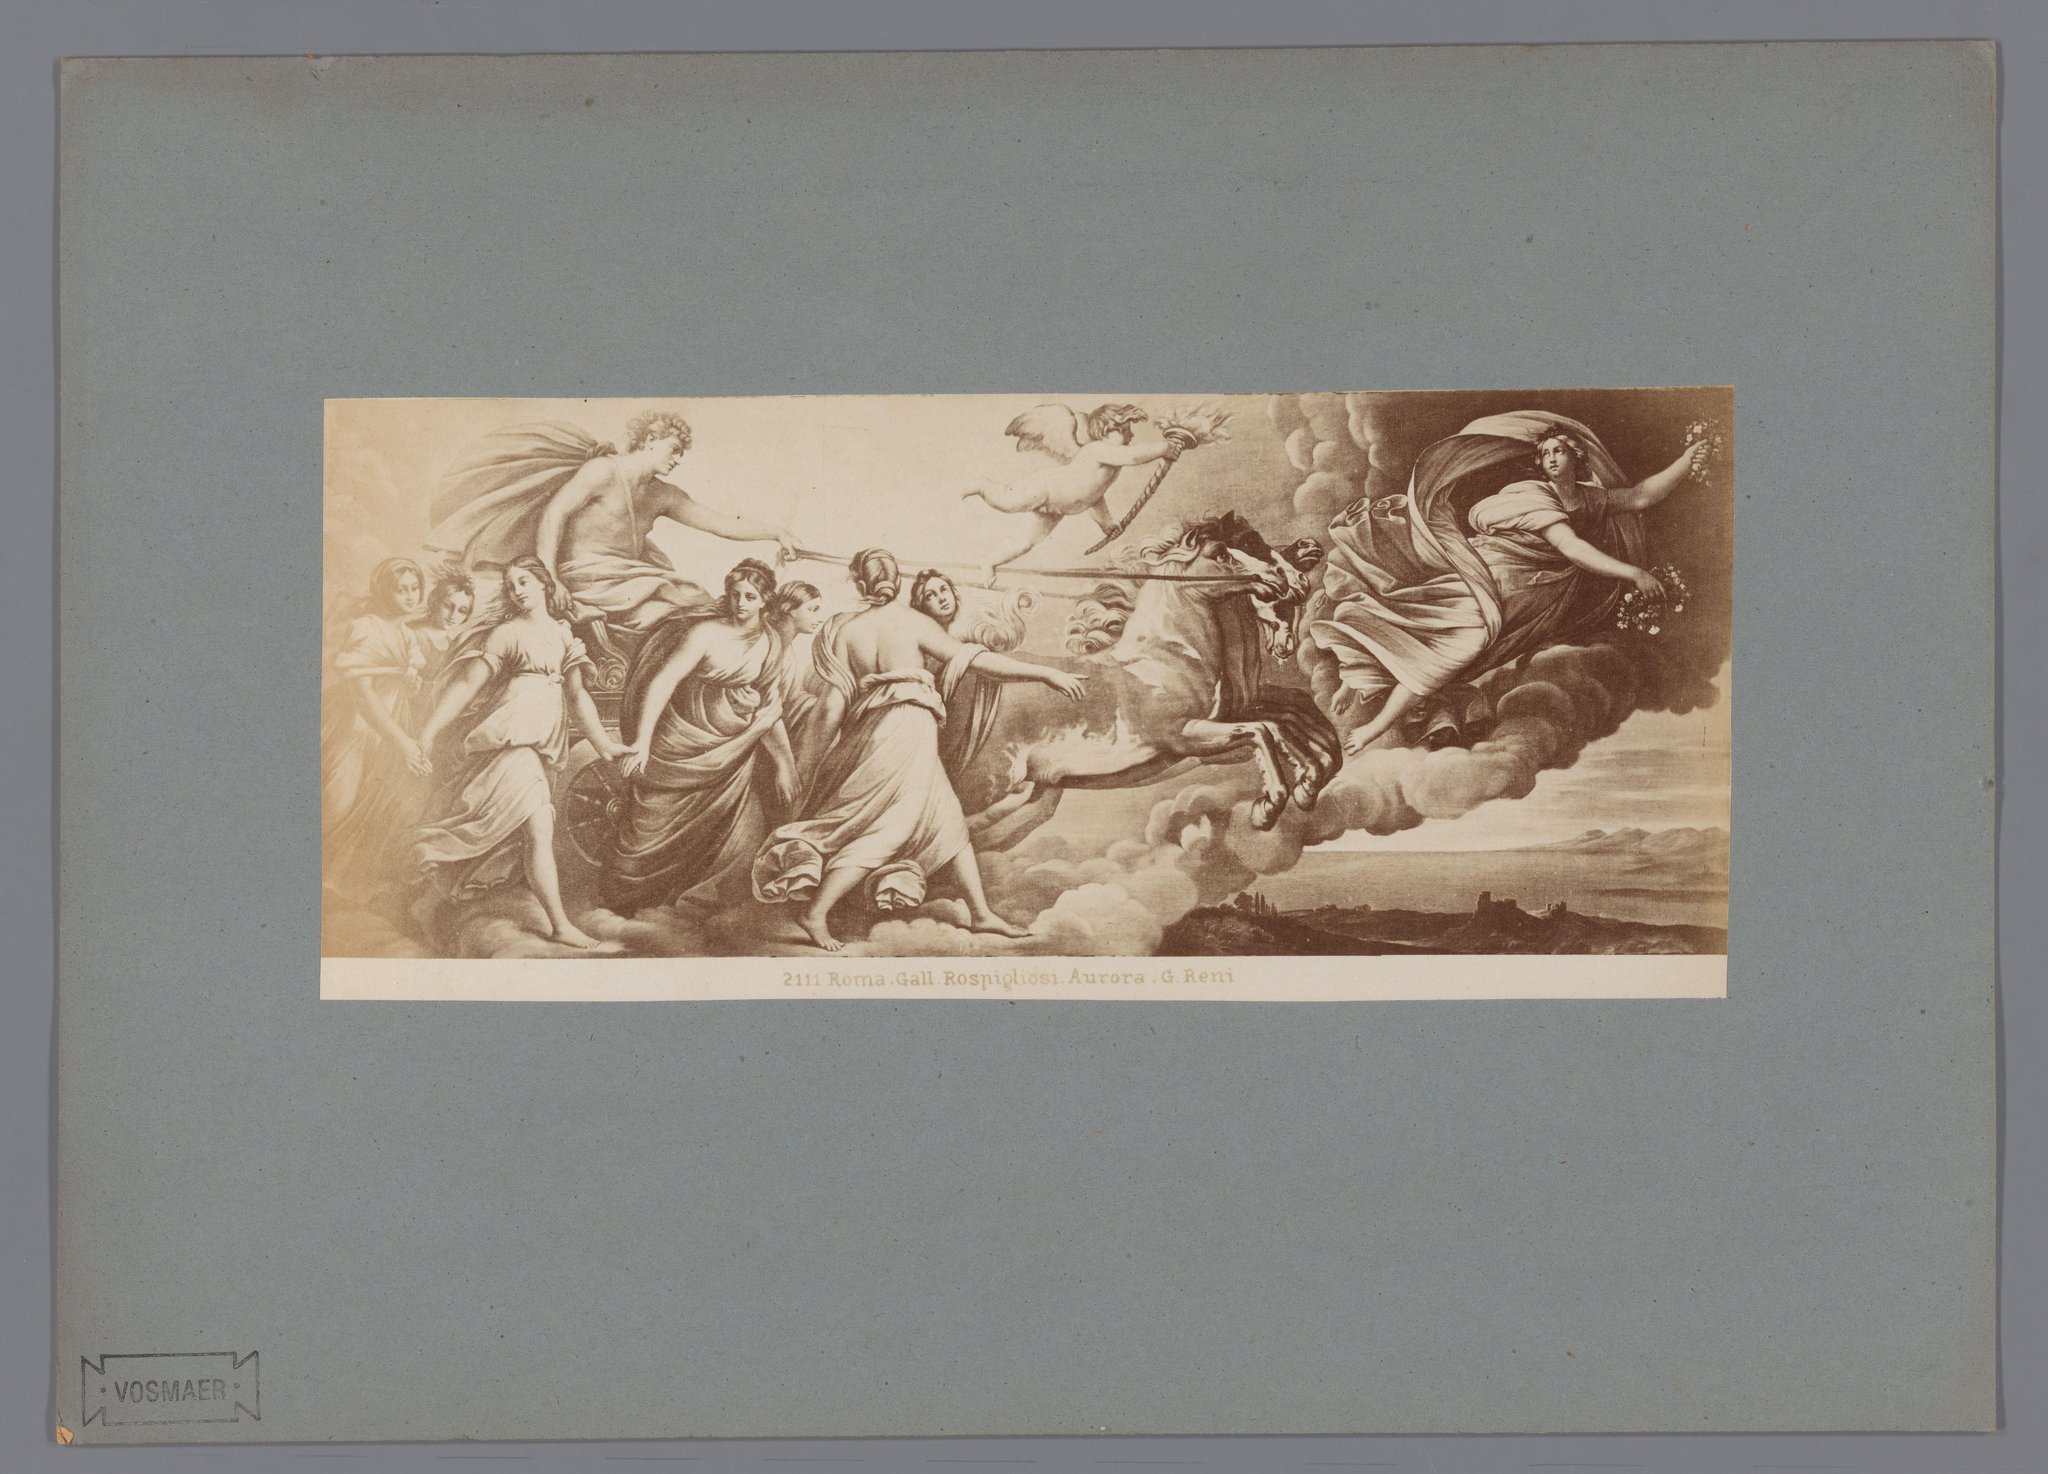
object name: reproduction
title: Roma. Gall. Rospigliosi. Aurora. G. Reni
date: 1851-1900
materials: cardboard, paper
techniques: albumen print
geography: rome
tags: picture, painting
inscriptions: collector's mark: ‘VOSMAER’, number: ‘2111’